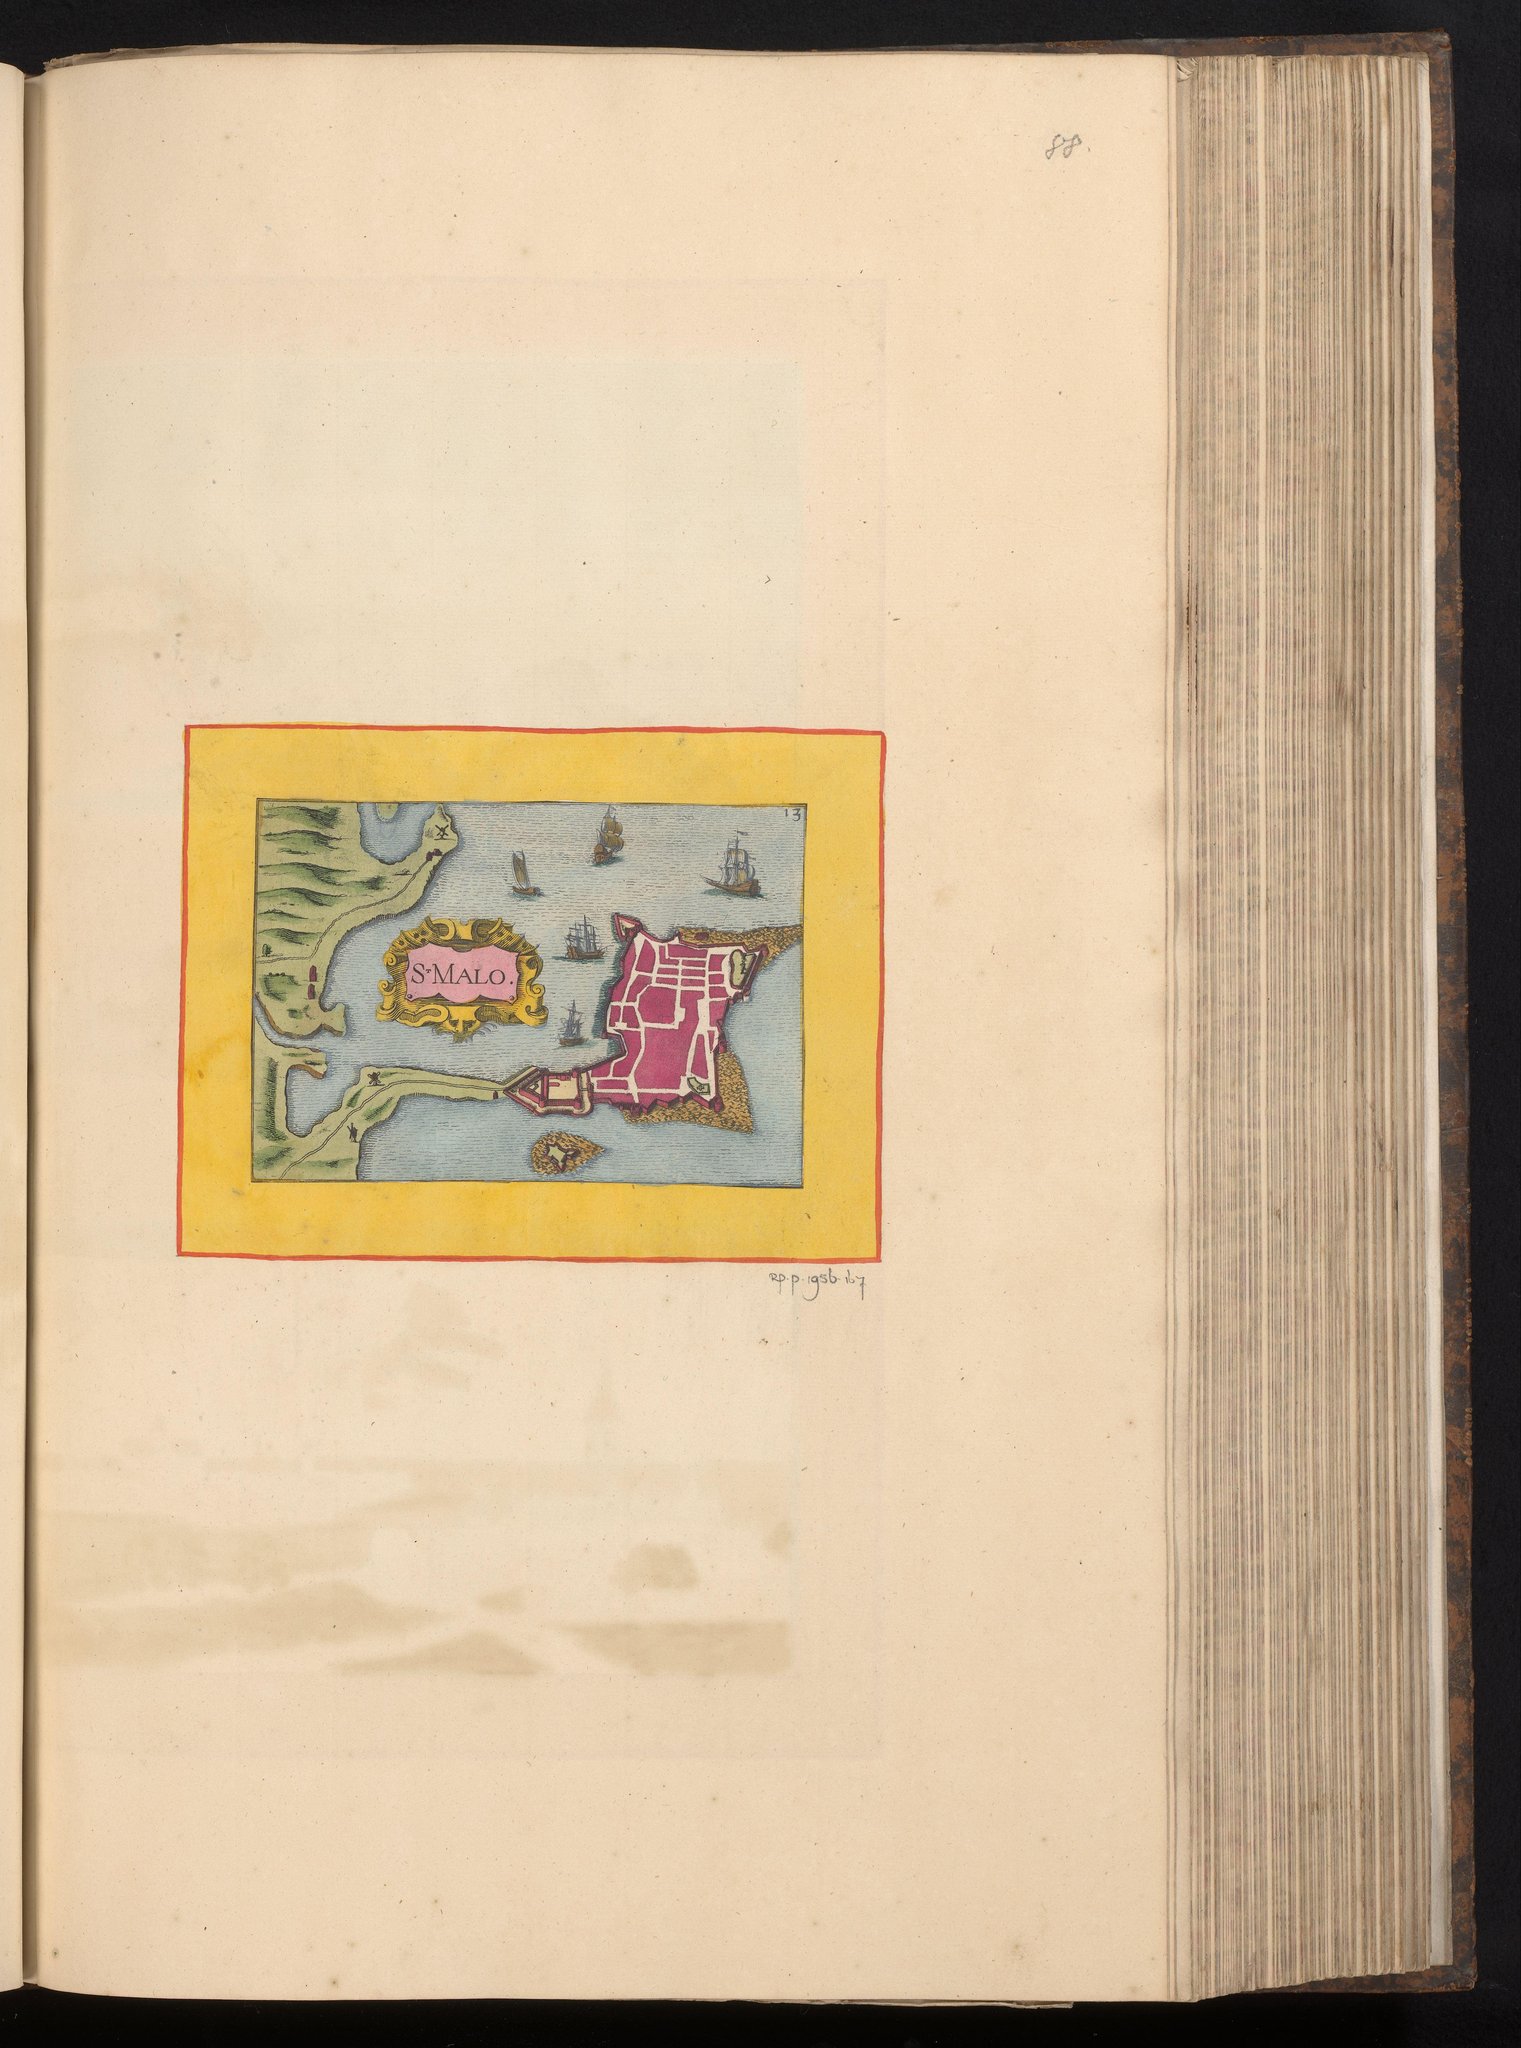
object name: print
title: St. Malo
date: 1638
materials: paper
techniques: engraving, etching, hand coloring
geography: the hague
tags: maps of cities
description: Prent uit: Tassin, Christophe. Les plans et profils de toutes les principales villes et lieux considérables de France (...). Parijs: Michel van Lochom, 1638, prent nummer 13 in het deel 'Bretaigne'.